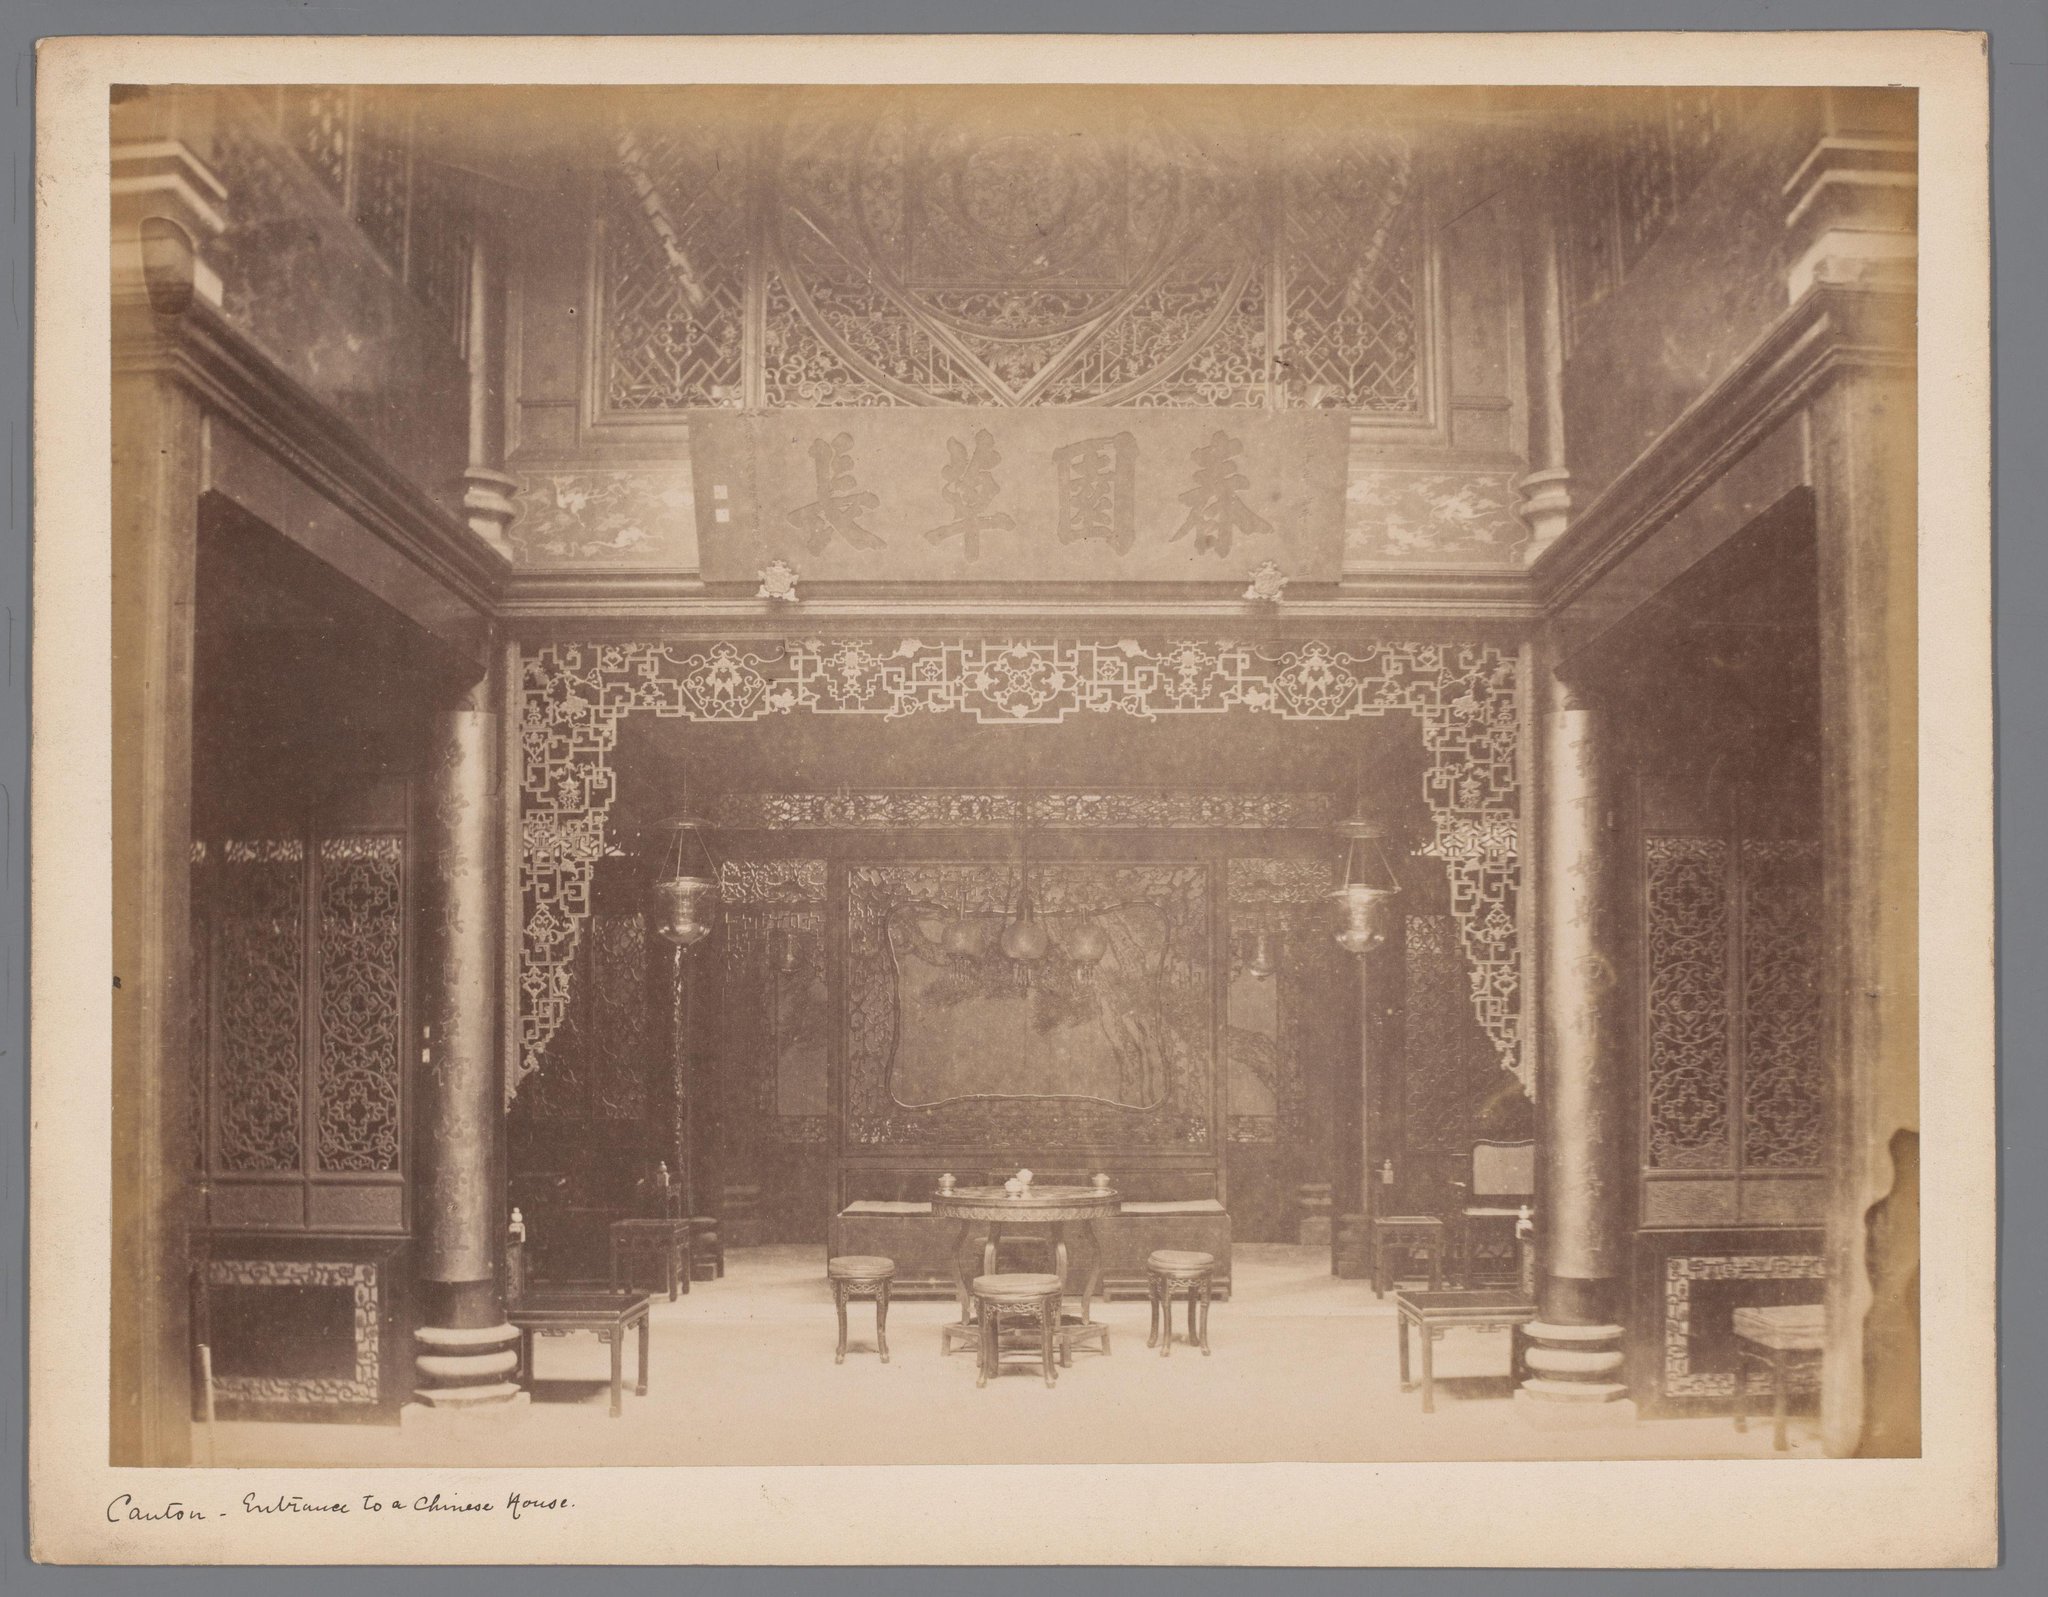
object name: photograph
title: Interieur van een Chinese woning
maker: Anonymous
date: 1850-1900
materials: cardboard, photographic support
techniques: albumen print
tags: interior of the house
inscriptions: annotation: ‘Canton-Entrance to a Chinese House’